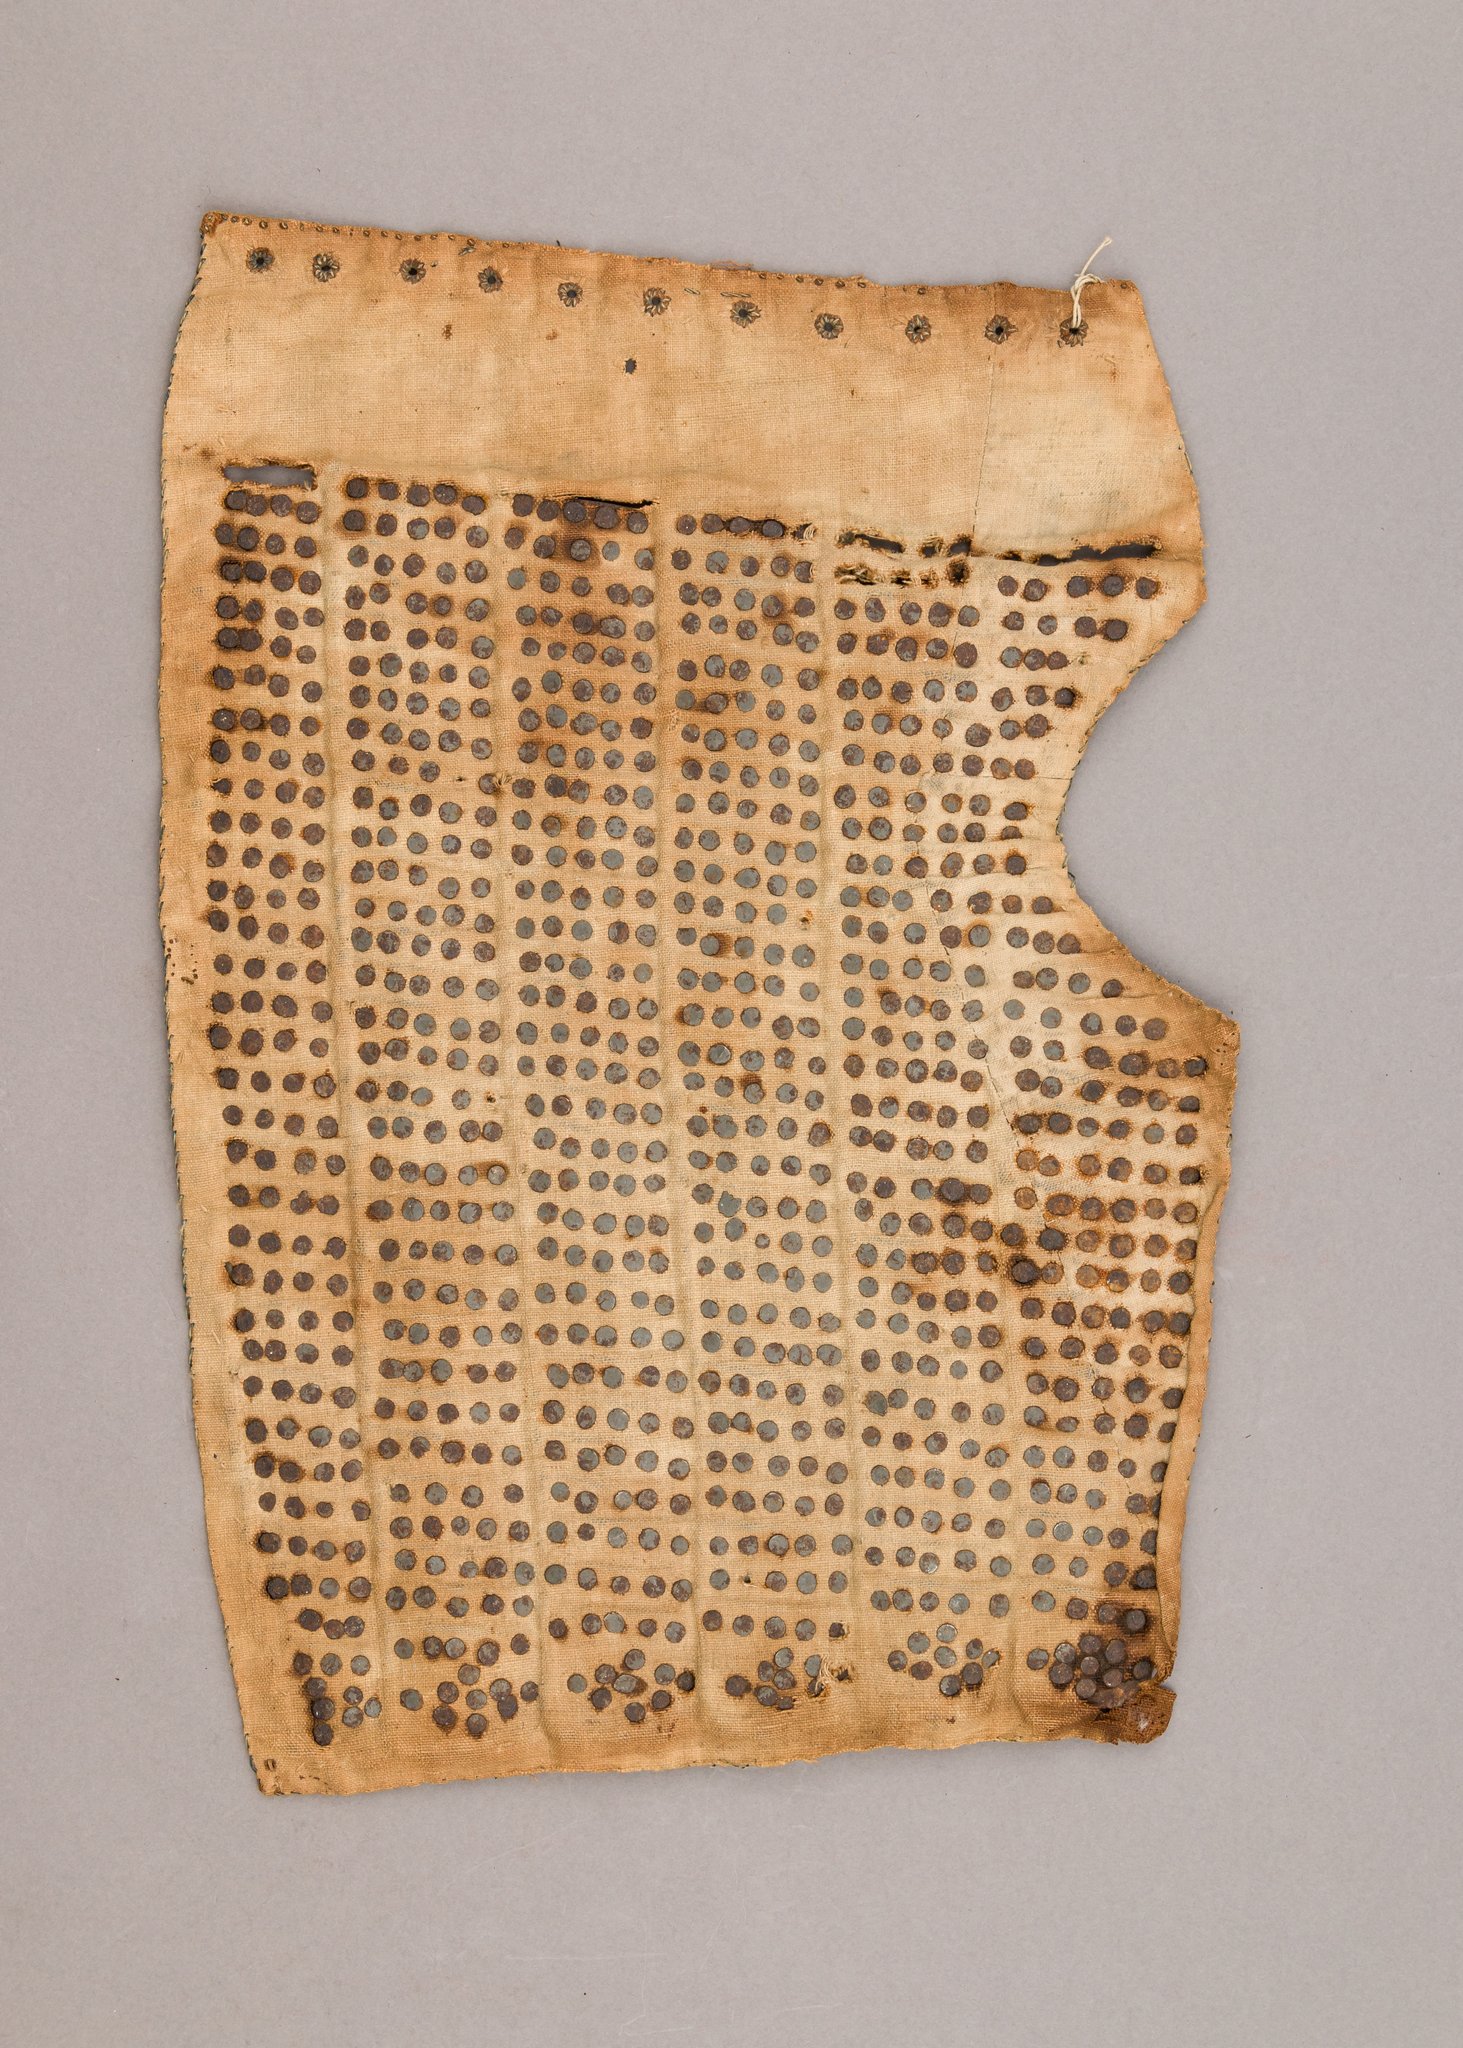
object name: part of a brigandine right thigh defense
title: Part of a Brigandine (Right Thigh Defense)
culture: italian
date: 1501-1533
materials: iron, textile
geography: italy